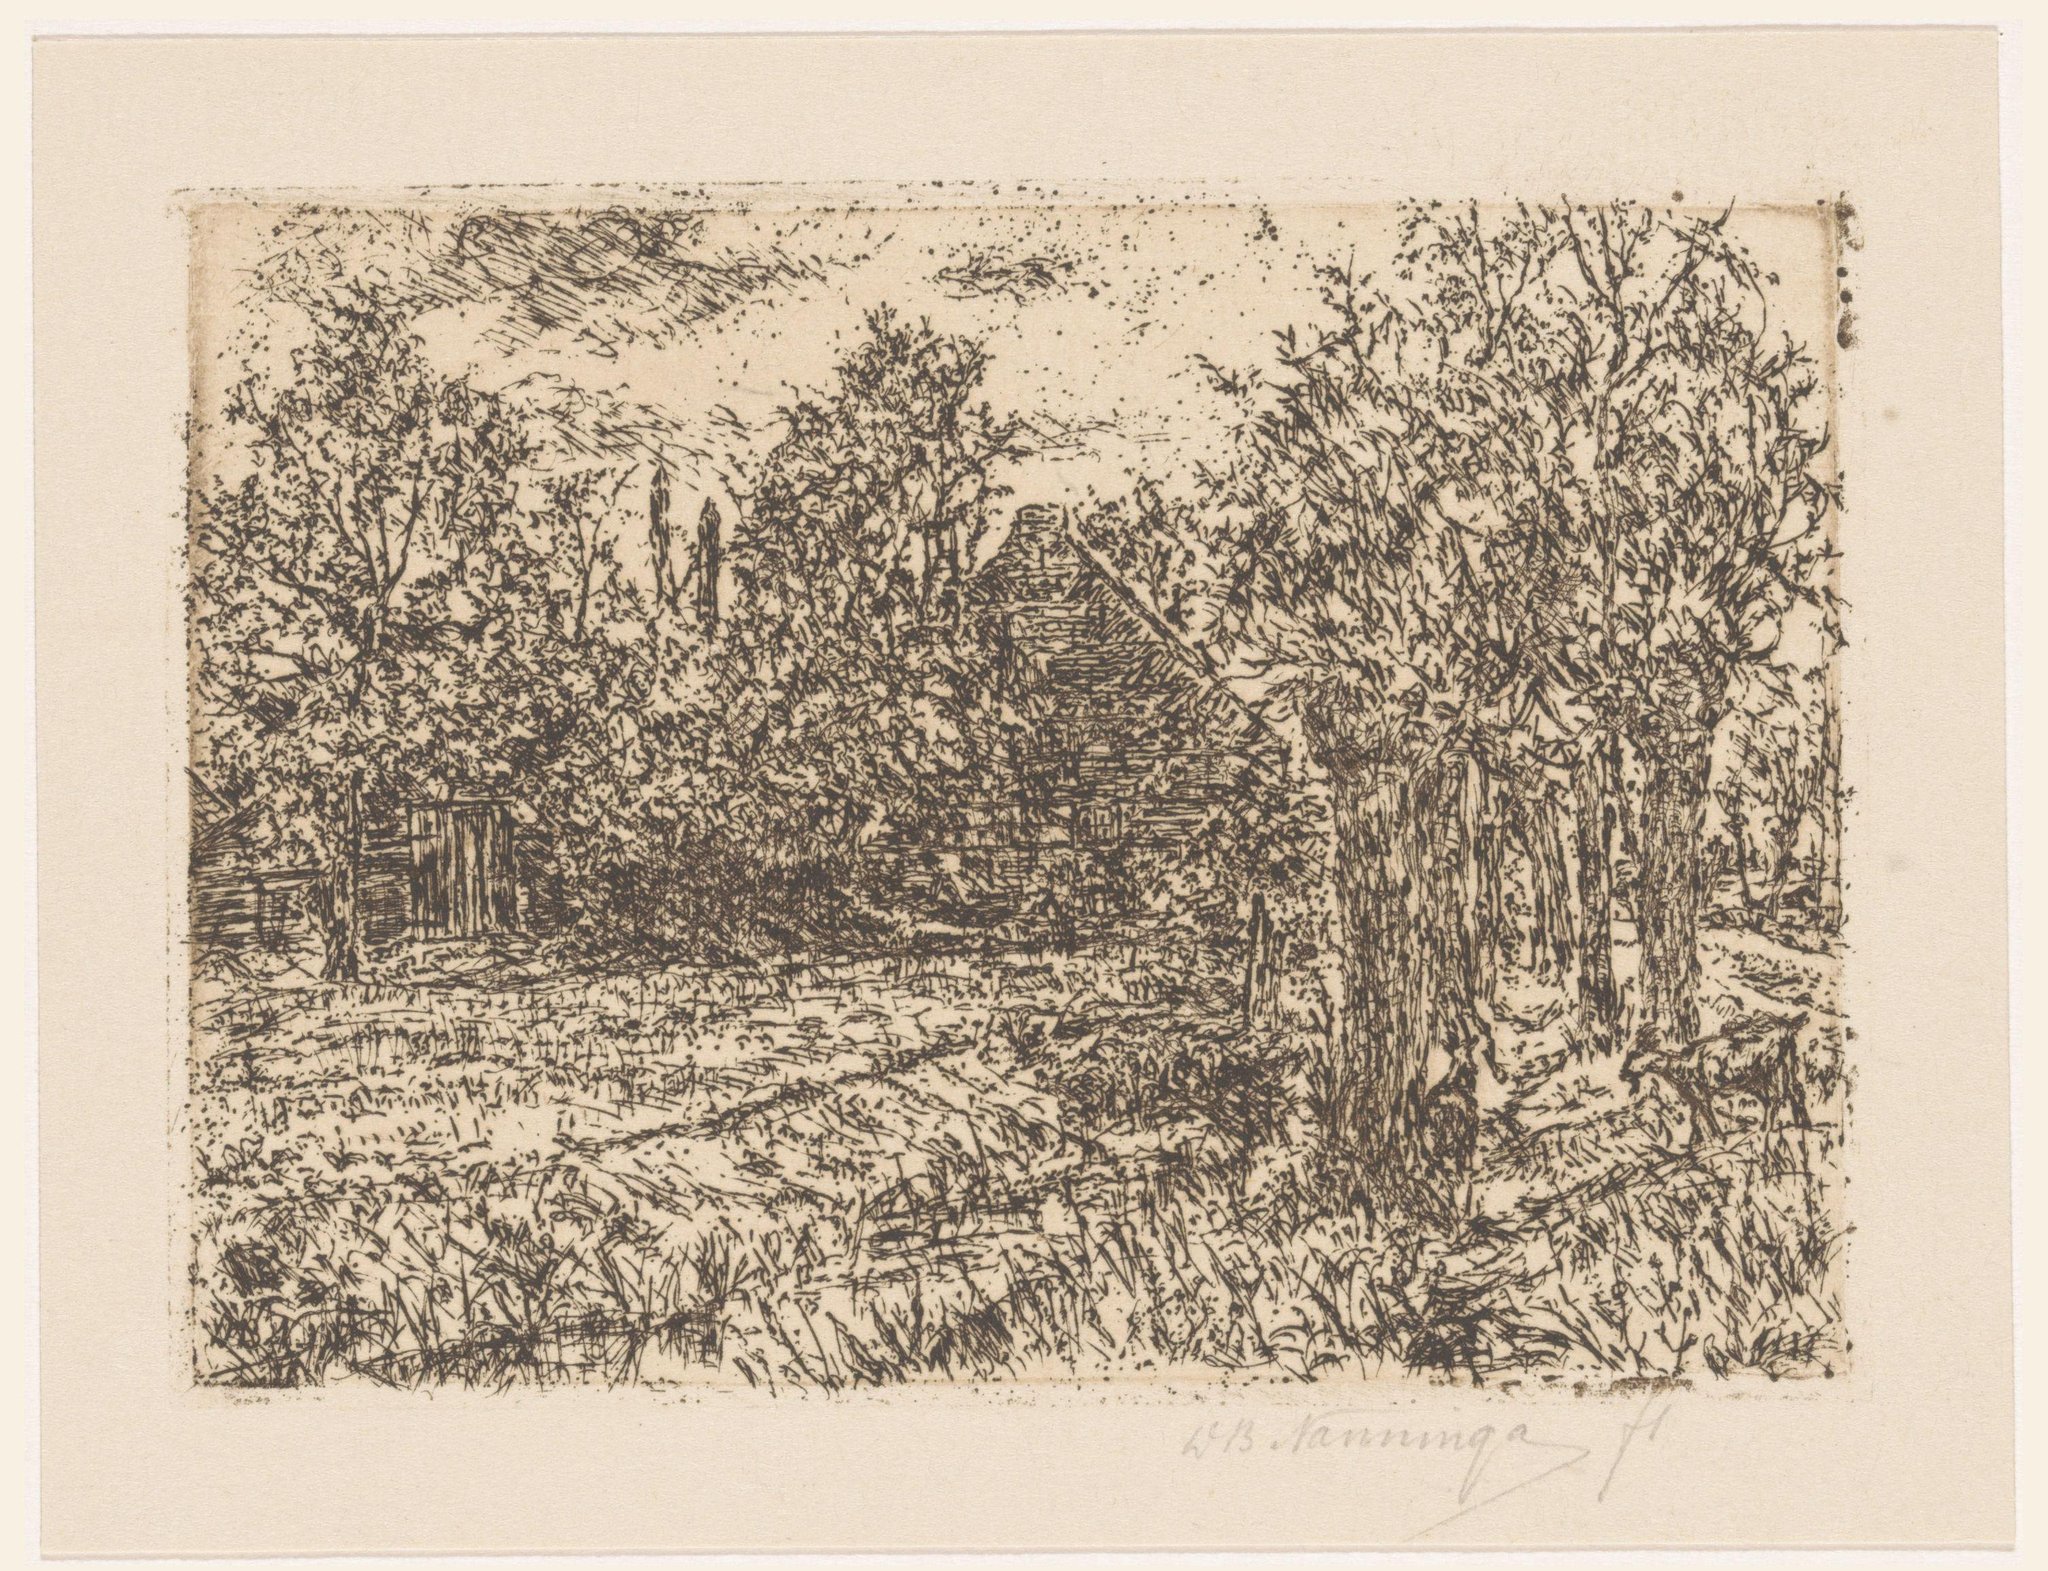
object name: print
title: Boerderij en wilgen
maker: dirk berend nanninga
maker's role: print maker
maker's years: 1868-1954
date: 1878-1931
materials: paper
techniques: etching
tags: farm or solitary house in landscape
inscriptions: collector's mark: Lugt 2228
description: Gezicht op een boerderij omgeven door bomen en struiken. Rechts staat een rij wilgen.